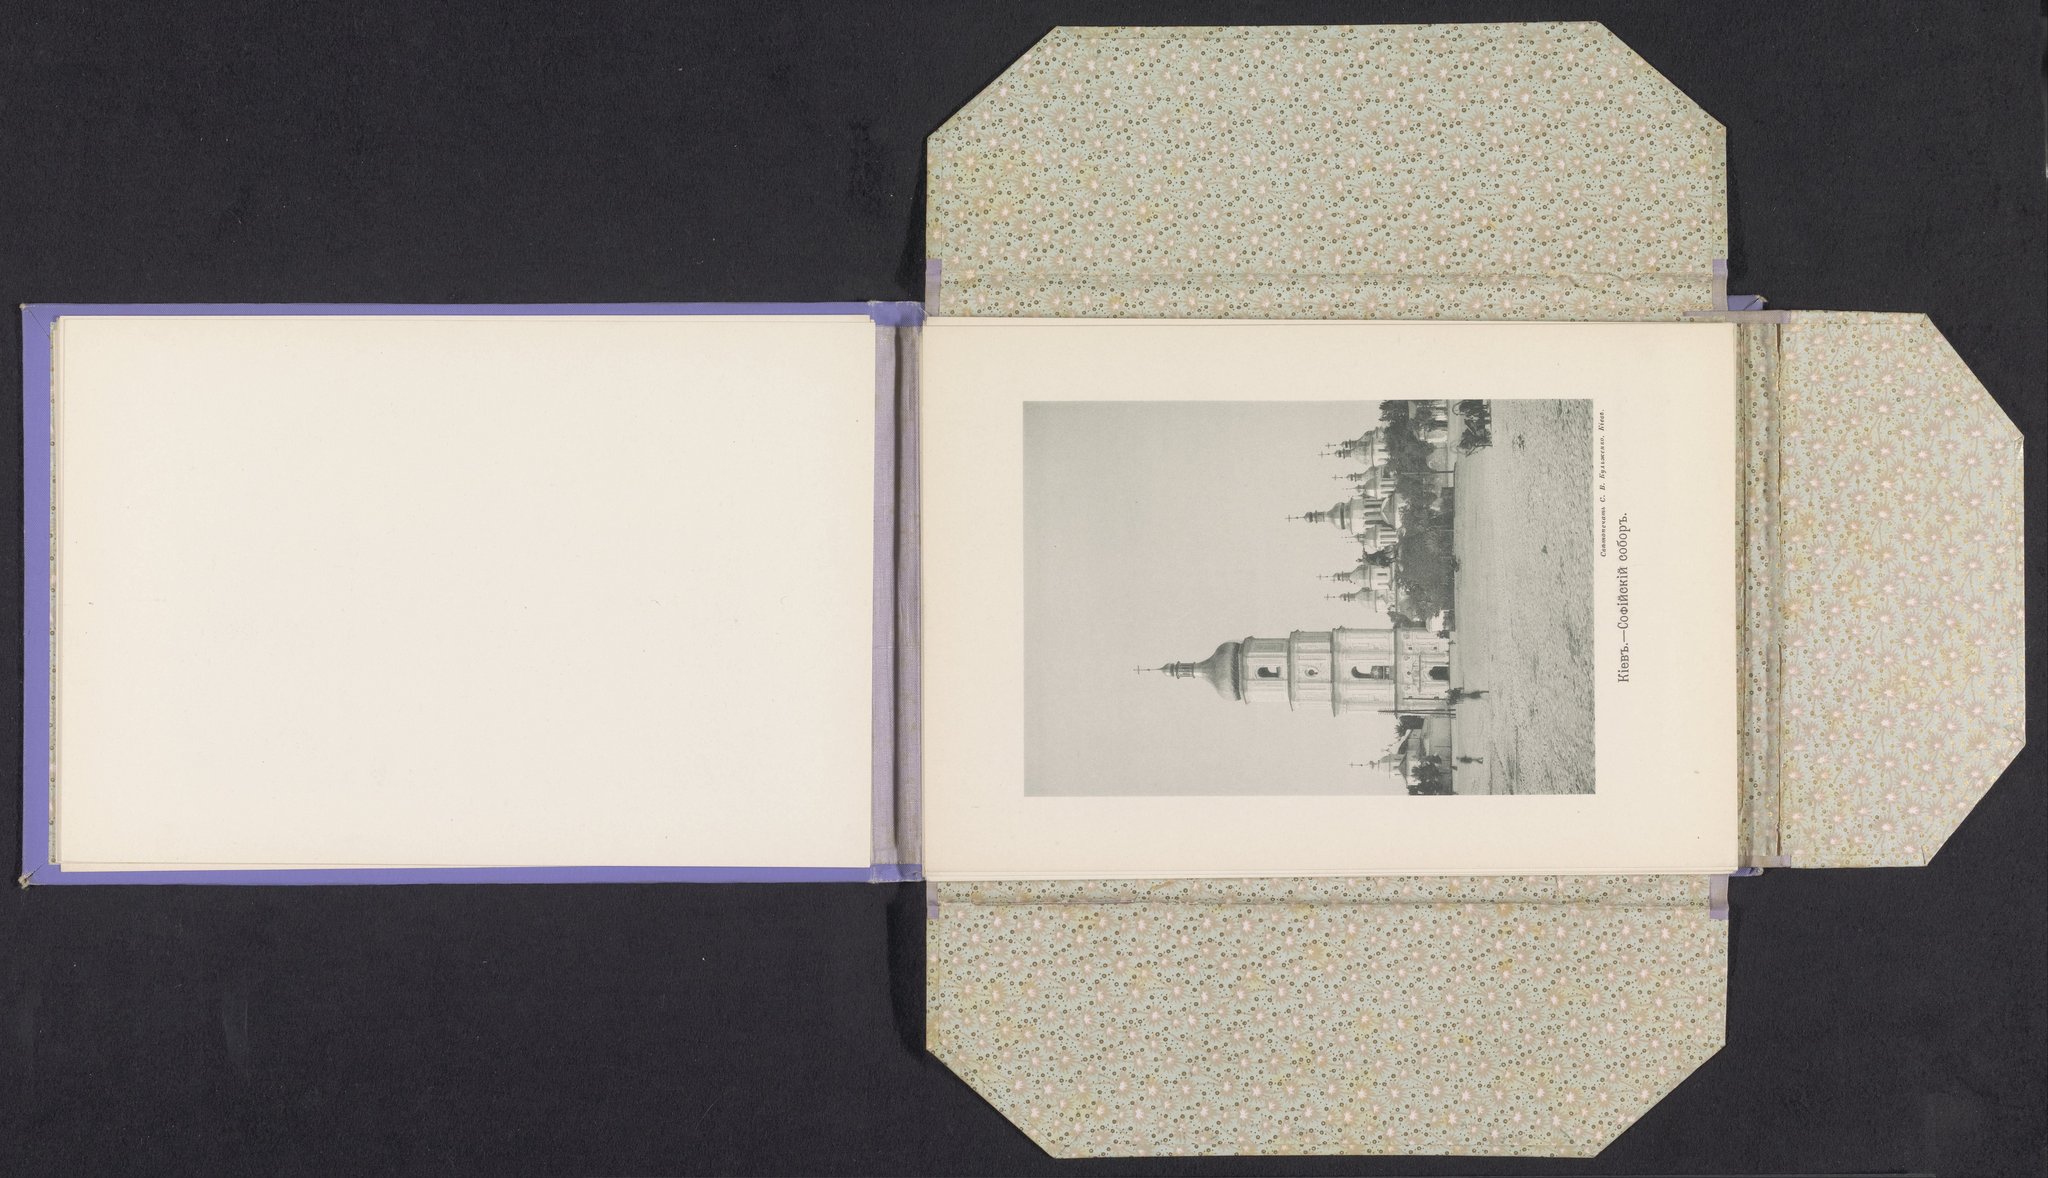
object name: photomechanical print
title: Exterieur van de Sint-Sofiakathedraal te Kiev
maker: Anonymous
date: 1886-1896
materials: paper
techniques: photograph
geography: kyiv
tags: church (exterior), façade (of house or building)